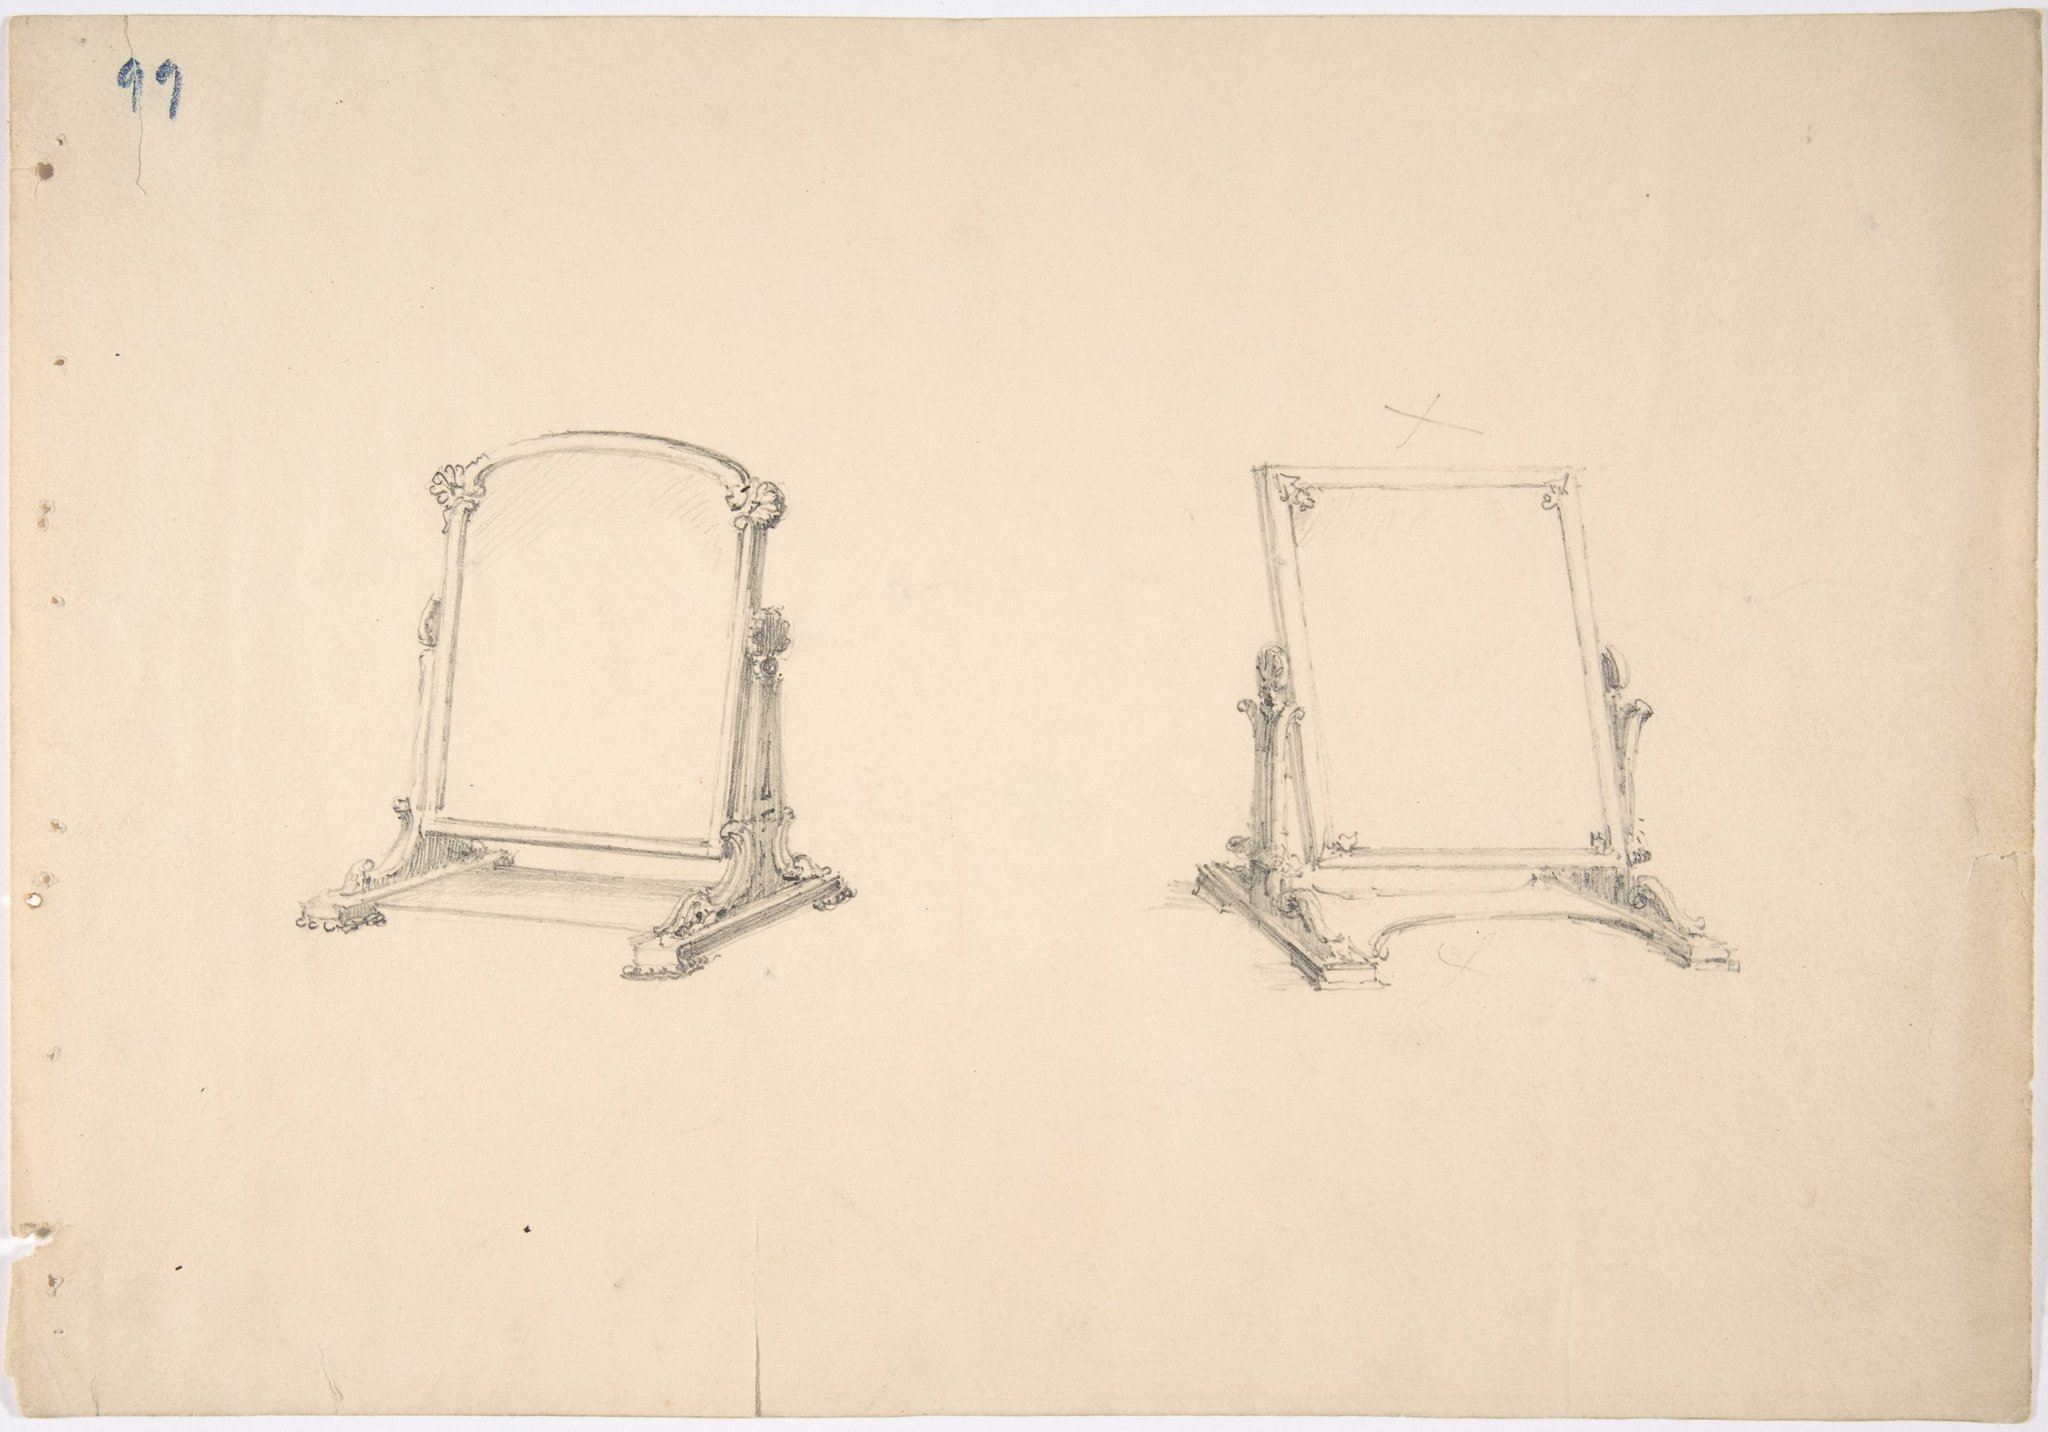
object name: drawing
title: Design for Two Ornamented Tabletop Mirrors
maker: anonymous, british, 19th century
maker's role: artist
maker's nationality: british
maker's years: 1800-1900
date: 1801-1833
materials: graphite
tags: mirrors